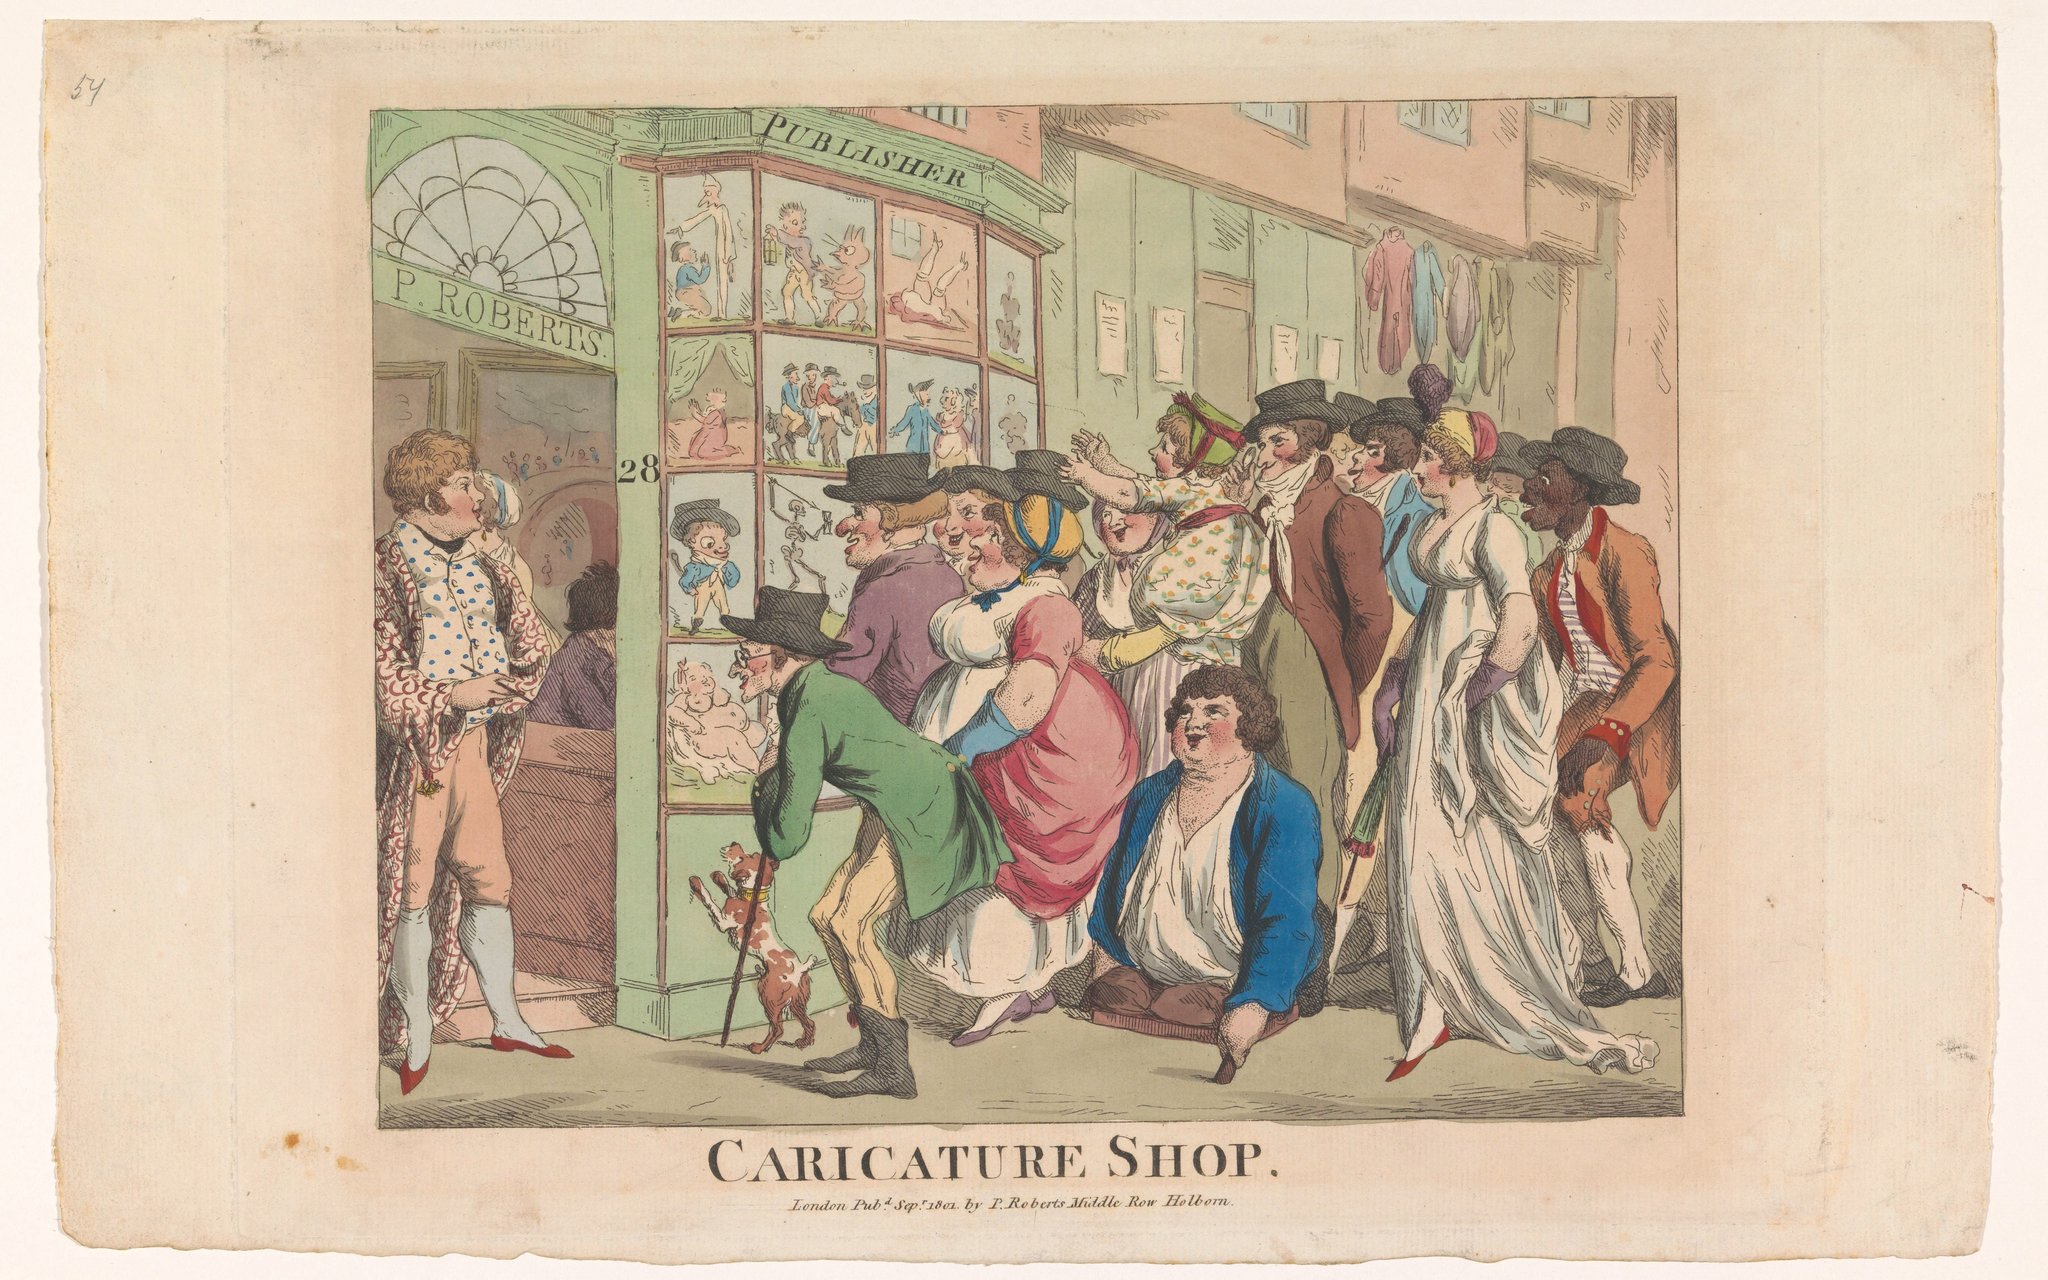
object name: print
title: Caricature Shop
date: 1801-1809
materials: paper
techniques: etching, hand coloring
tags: print maker, draughtsman, piercy roberts, caricatures (human types), print, e.g.: engraving, etching, lithograph, art dealer (+ graphic arts), africans, person with a physical disability, shop-window, show-window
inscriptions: collector's mark: Lugt 4779, collector's mark: Lugt 2228, watermark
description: Menigte voor de etalage van karikaturist, prentmaker en uitgever Piercy Roberts, Middle Row 28, Holborn. Onder het publiek bevinden zich een meisje dat haar handen uitstrekt naar de prenten, een man zonder benen en een zwarte man. In de deuropening staat een man, waarschijnlijk Percy Roberts zelf.